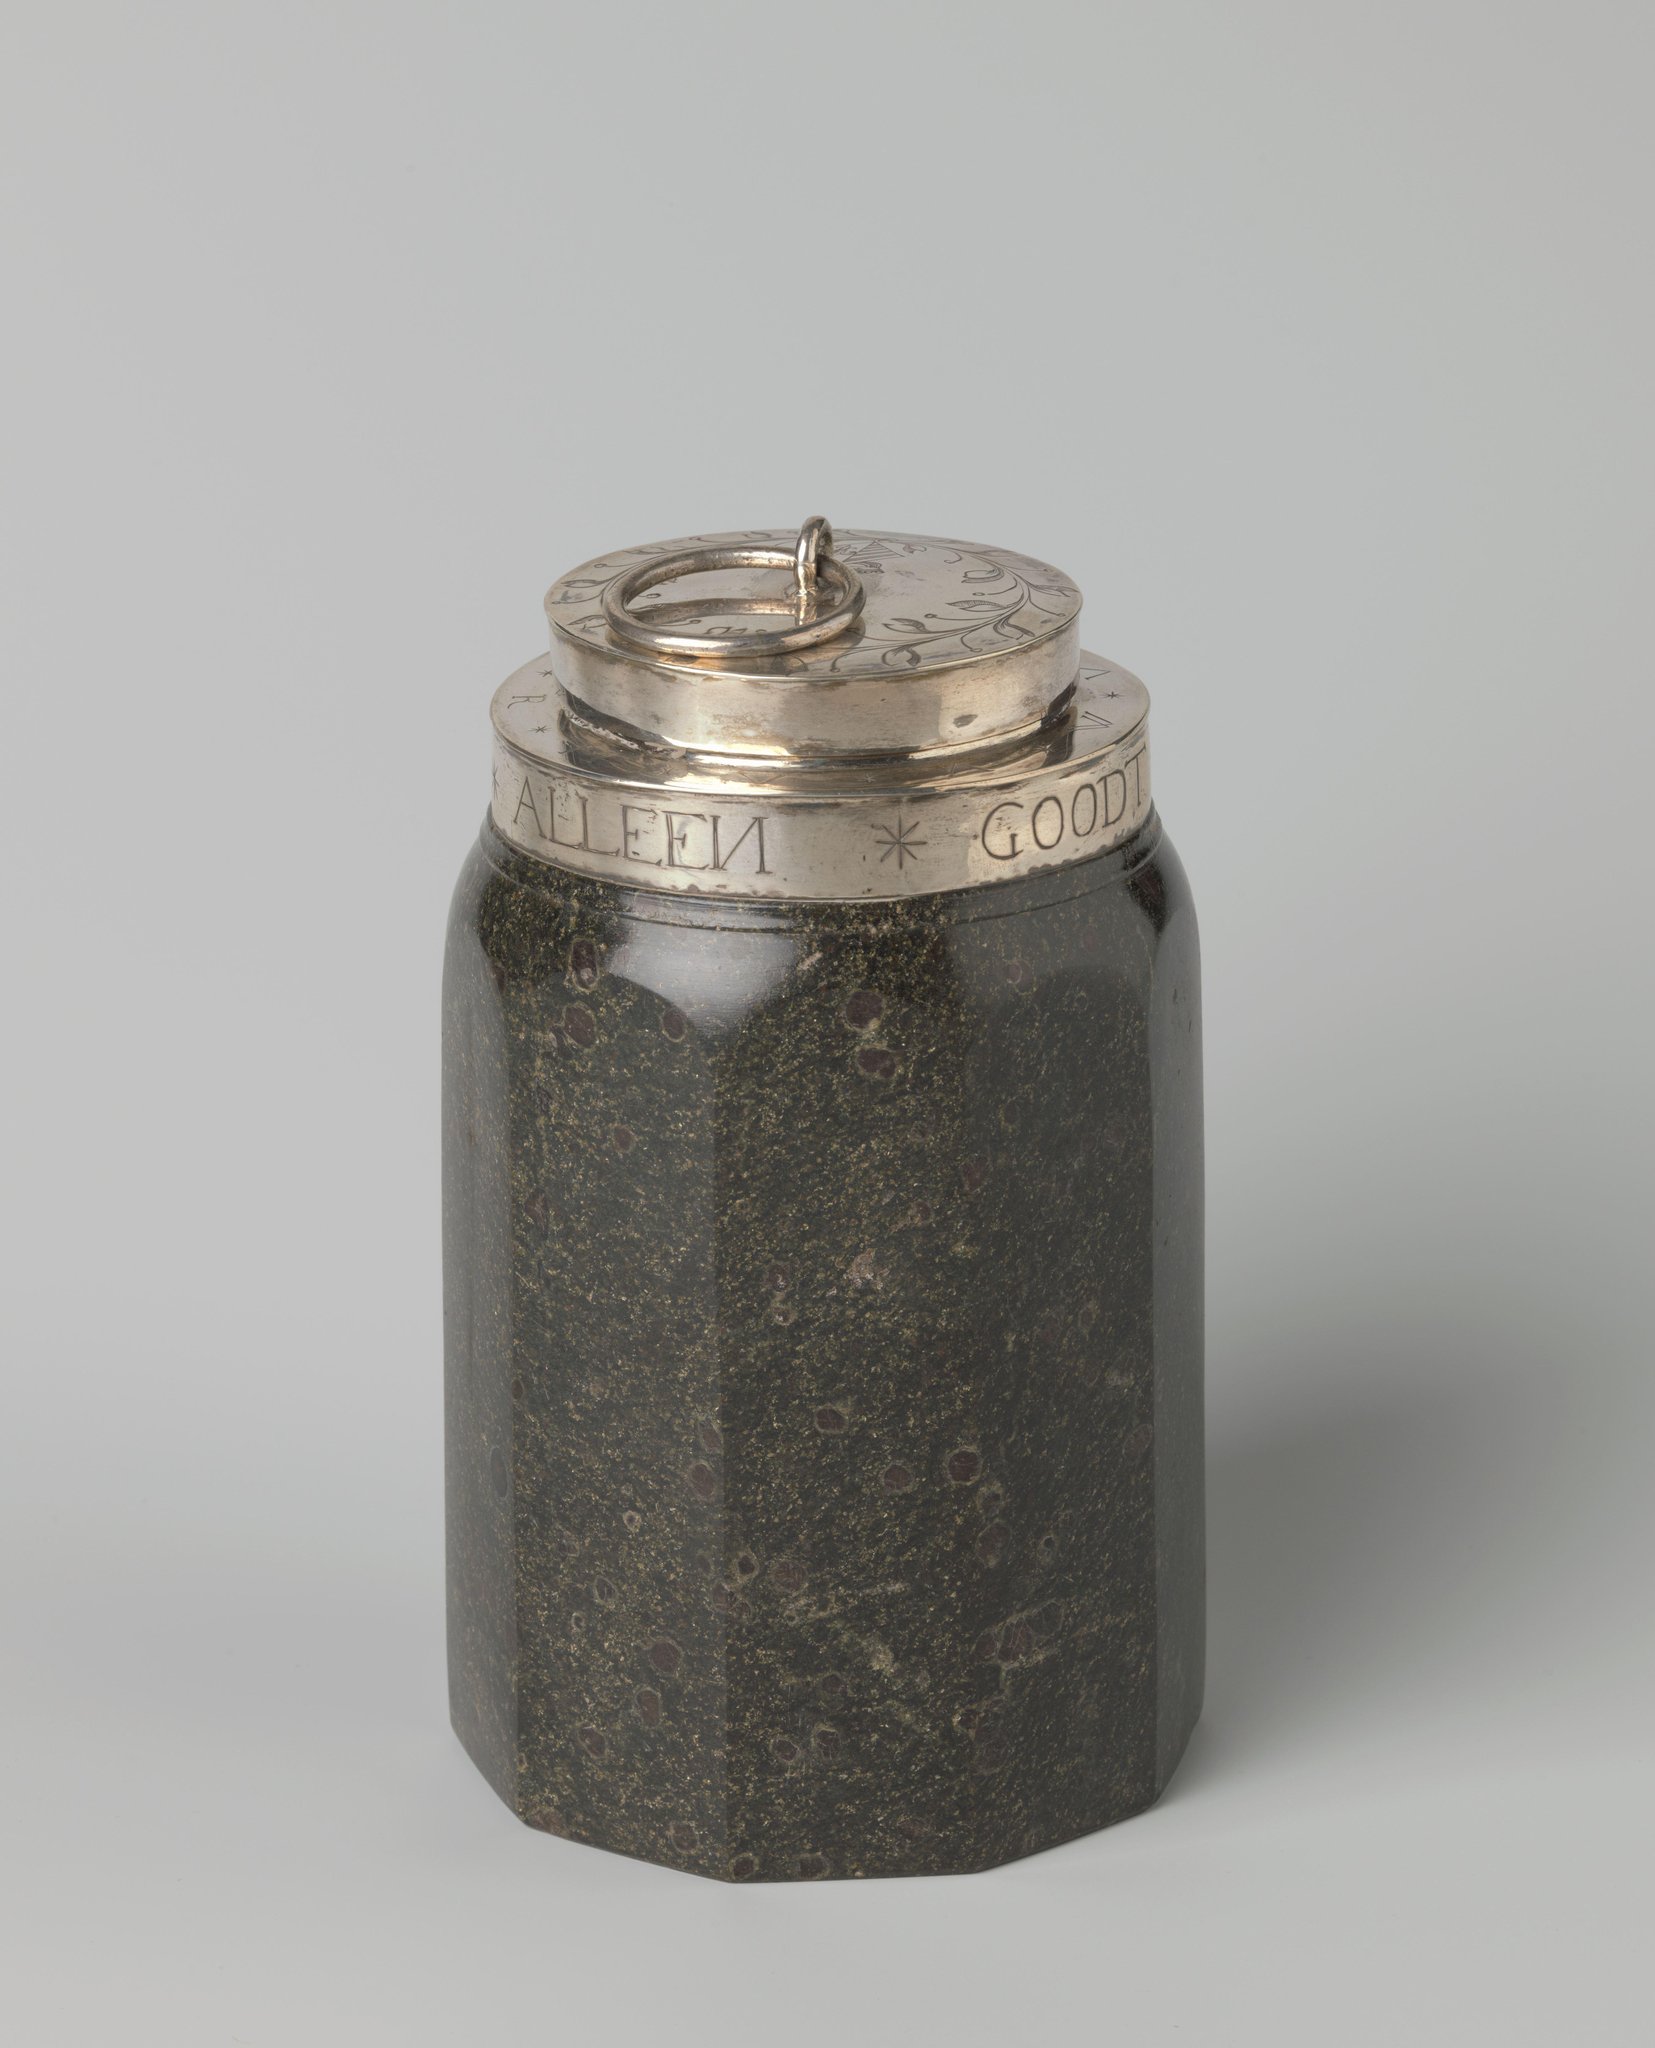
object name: pot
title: Jar with a Screw Cover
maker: Anonymous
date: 1638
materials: stone, silver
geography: netherlands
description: Pot van serpentijnsteen, met zilveren schroefdeksel. De pot is tienhoekig van vorm. Op het deksel is binnen een bladkrans gegraveerd het wapen van Margaretha van Aeswijn, Weduwe van Munster, Vrouwe van Runen (geb. ca. 1590, overl.1657), gehuwd 1625 met Hendrik van munster tot tuyll, heer van Ruinen (overleden te Ruinen, 1635-01-27), maakte haar testament op 08-07 en 20-10-1656en 29-01-1657).Op de zilveren randen: M*V*A*W*V*V*R* en ALLEEN*GOODT*DIE*EER*ANNO*1638*. Het zilver is ongemerkt.